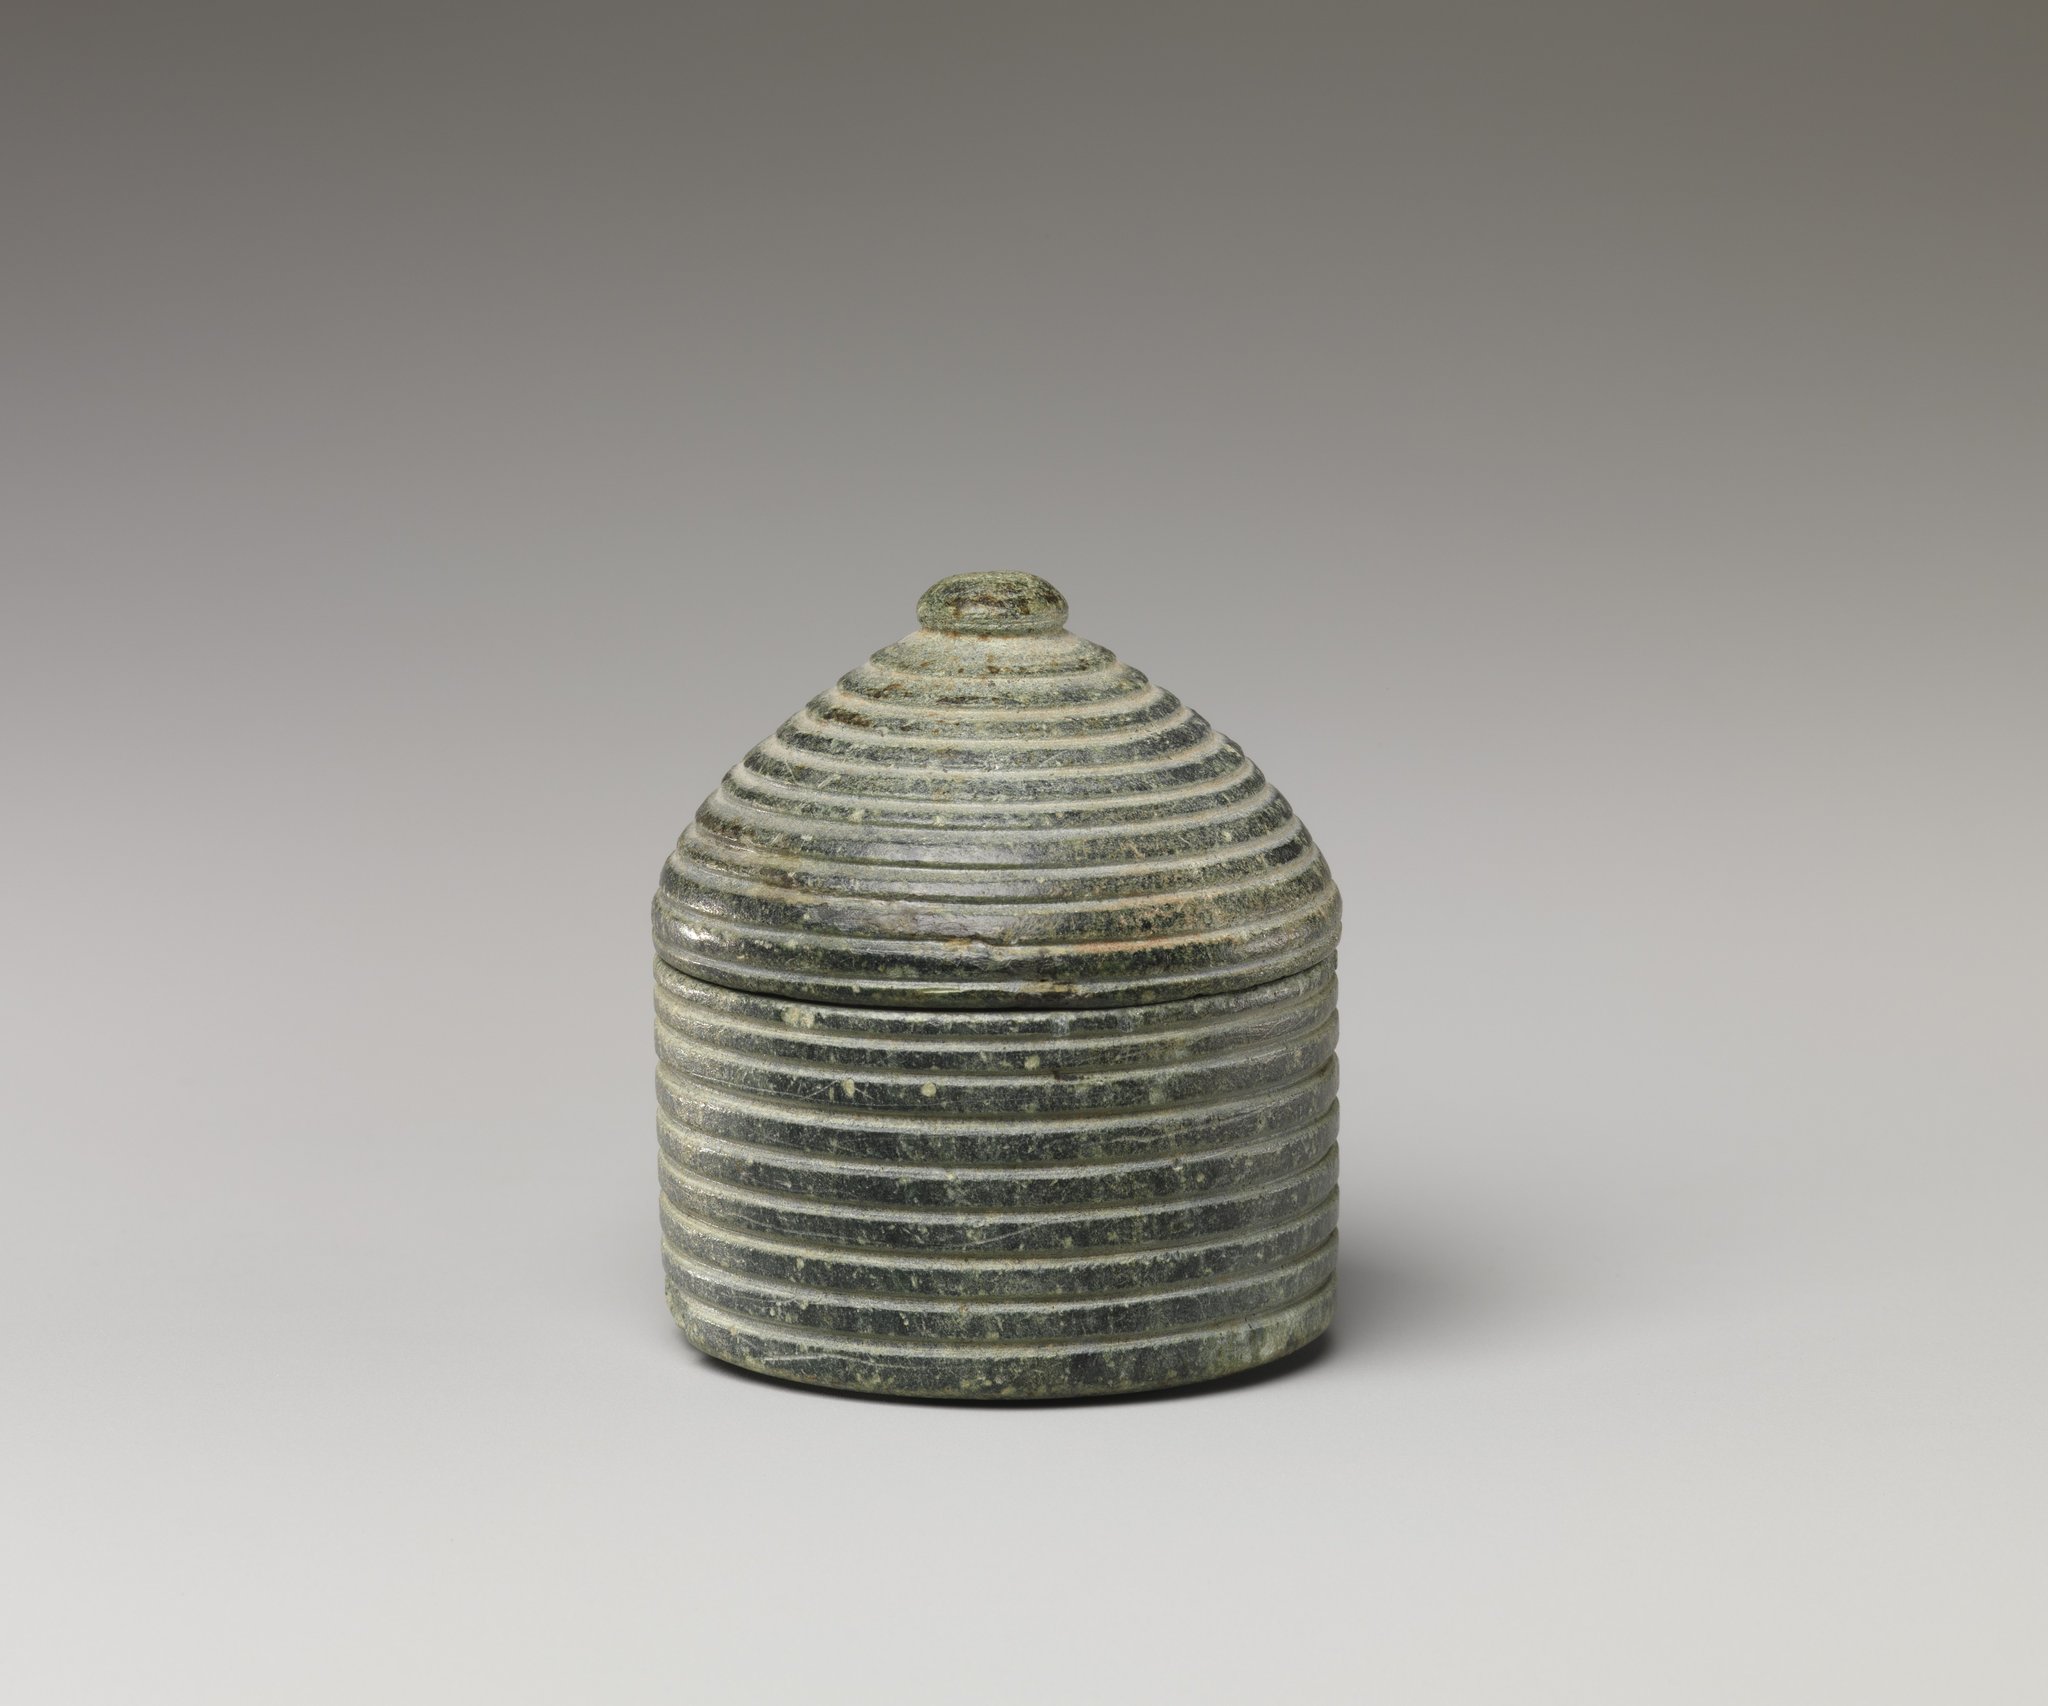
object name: reliquary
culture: gandhara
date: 101-300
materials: stone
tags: gandhara